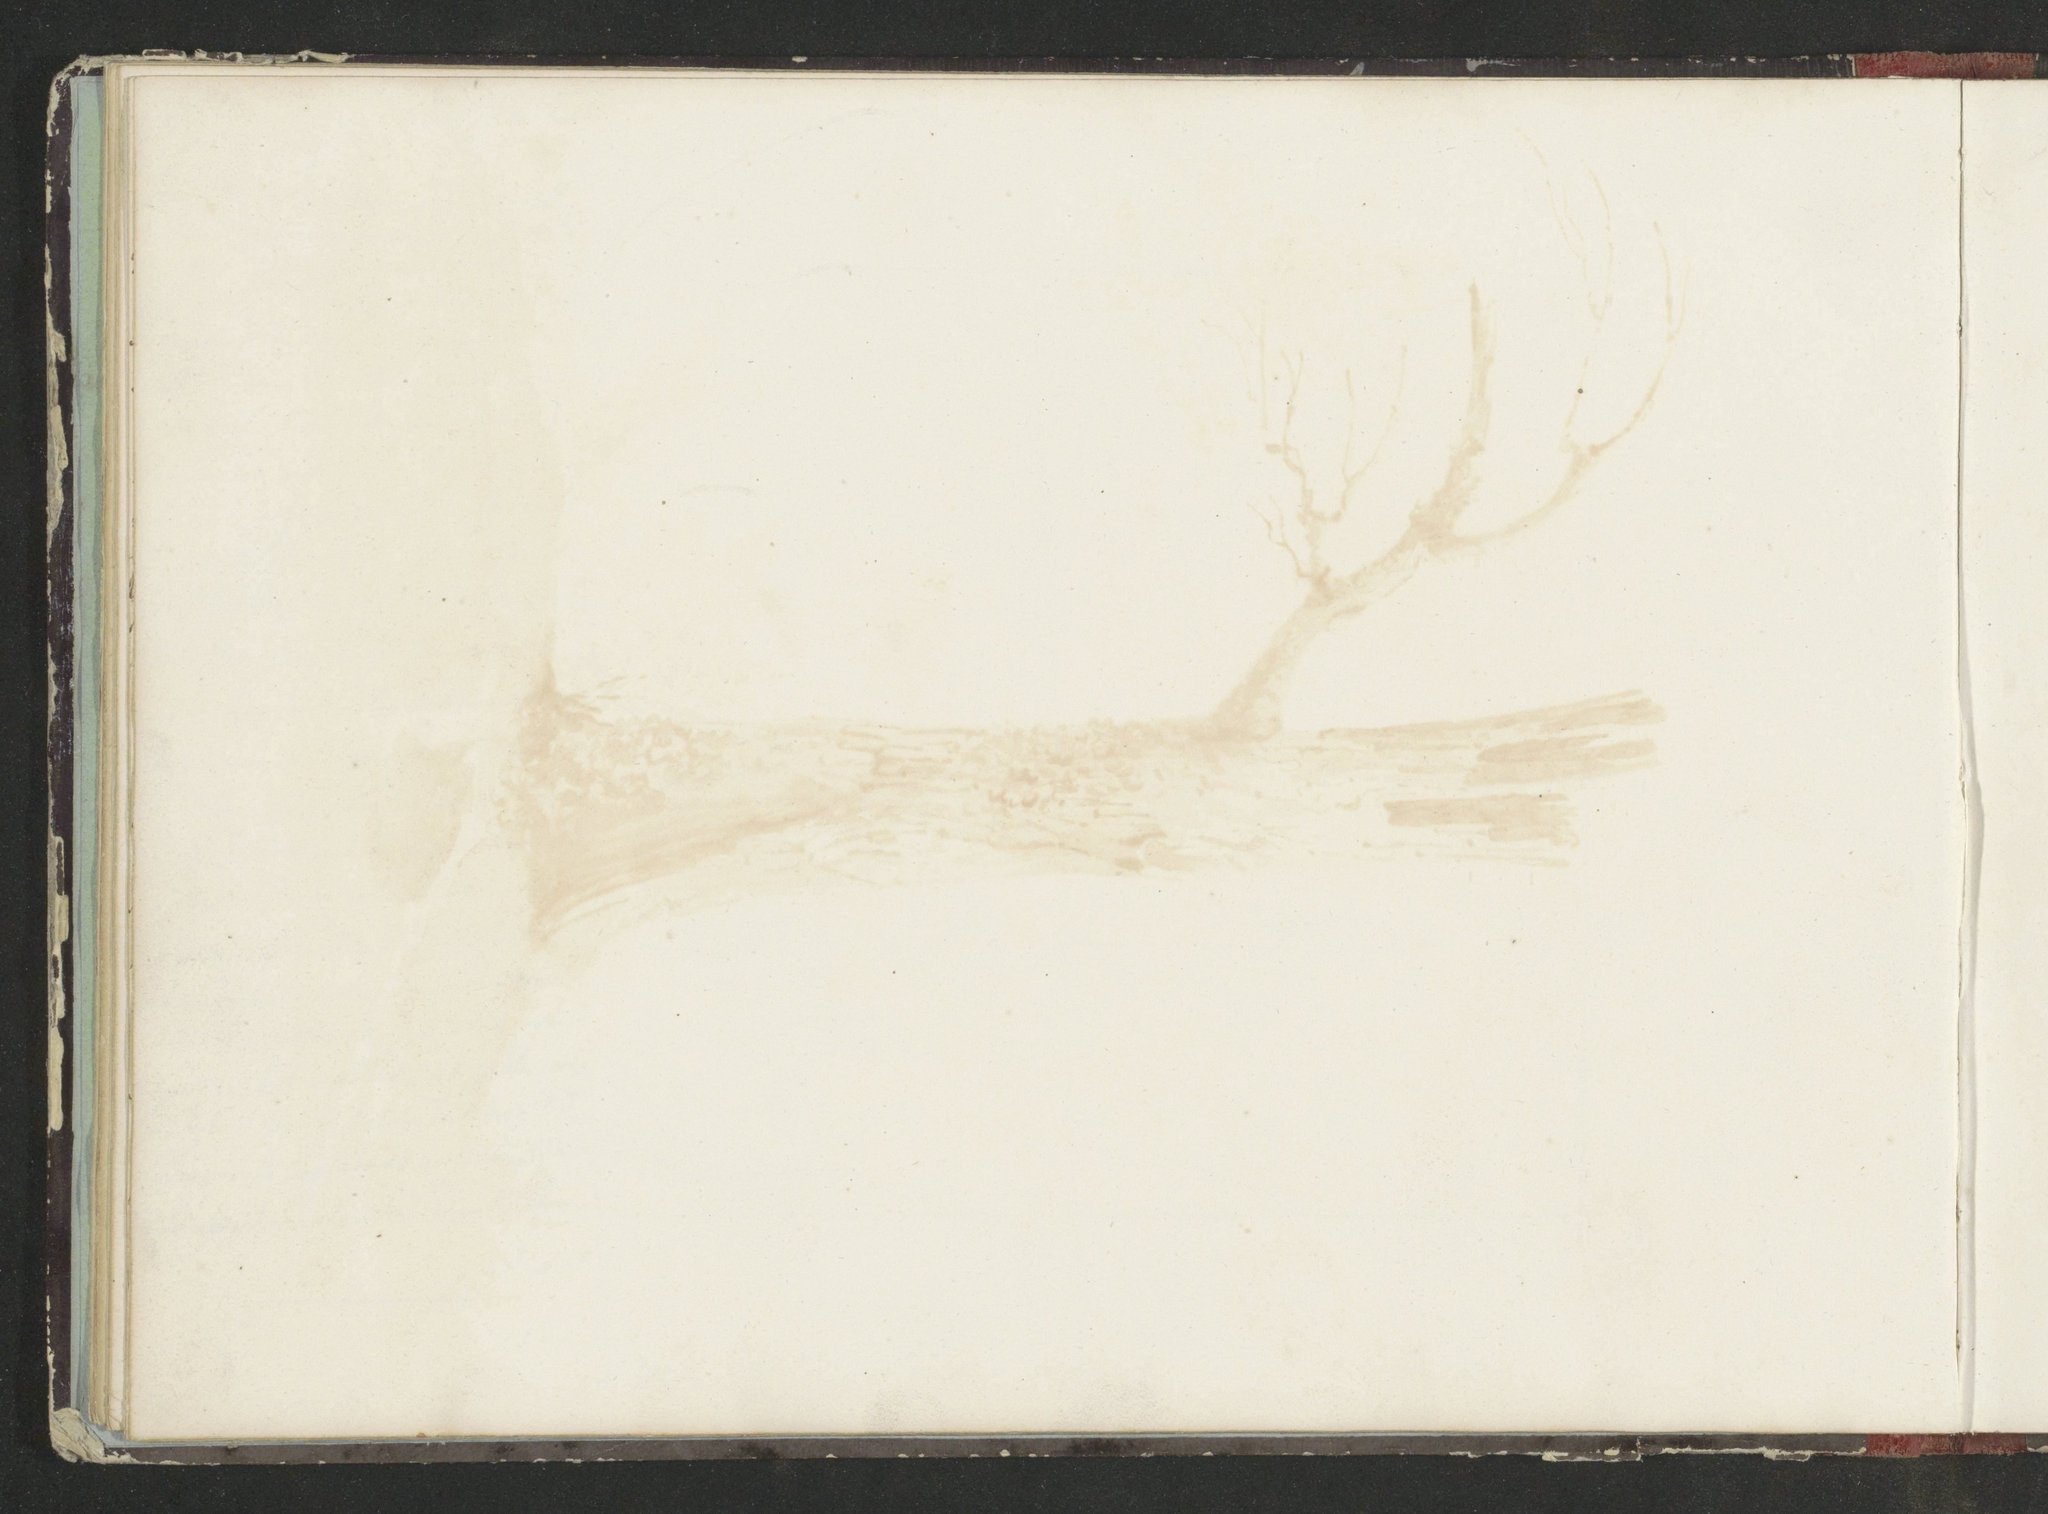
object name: sketchbook leaf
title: Abklatsch van de tekening op blad 12 recto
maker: Anonymous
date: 1819-1870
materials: paper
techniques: printmaking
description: Blad 11 verso uit een schetsboek met 39 bladen.